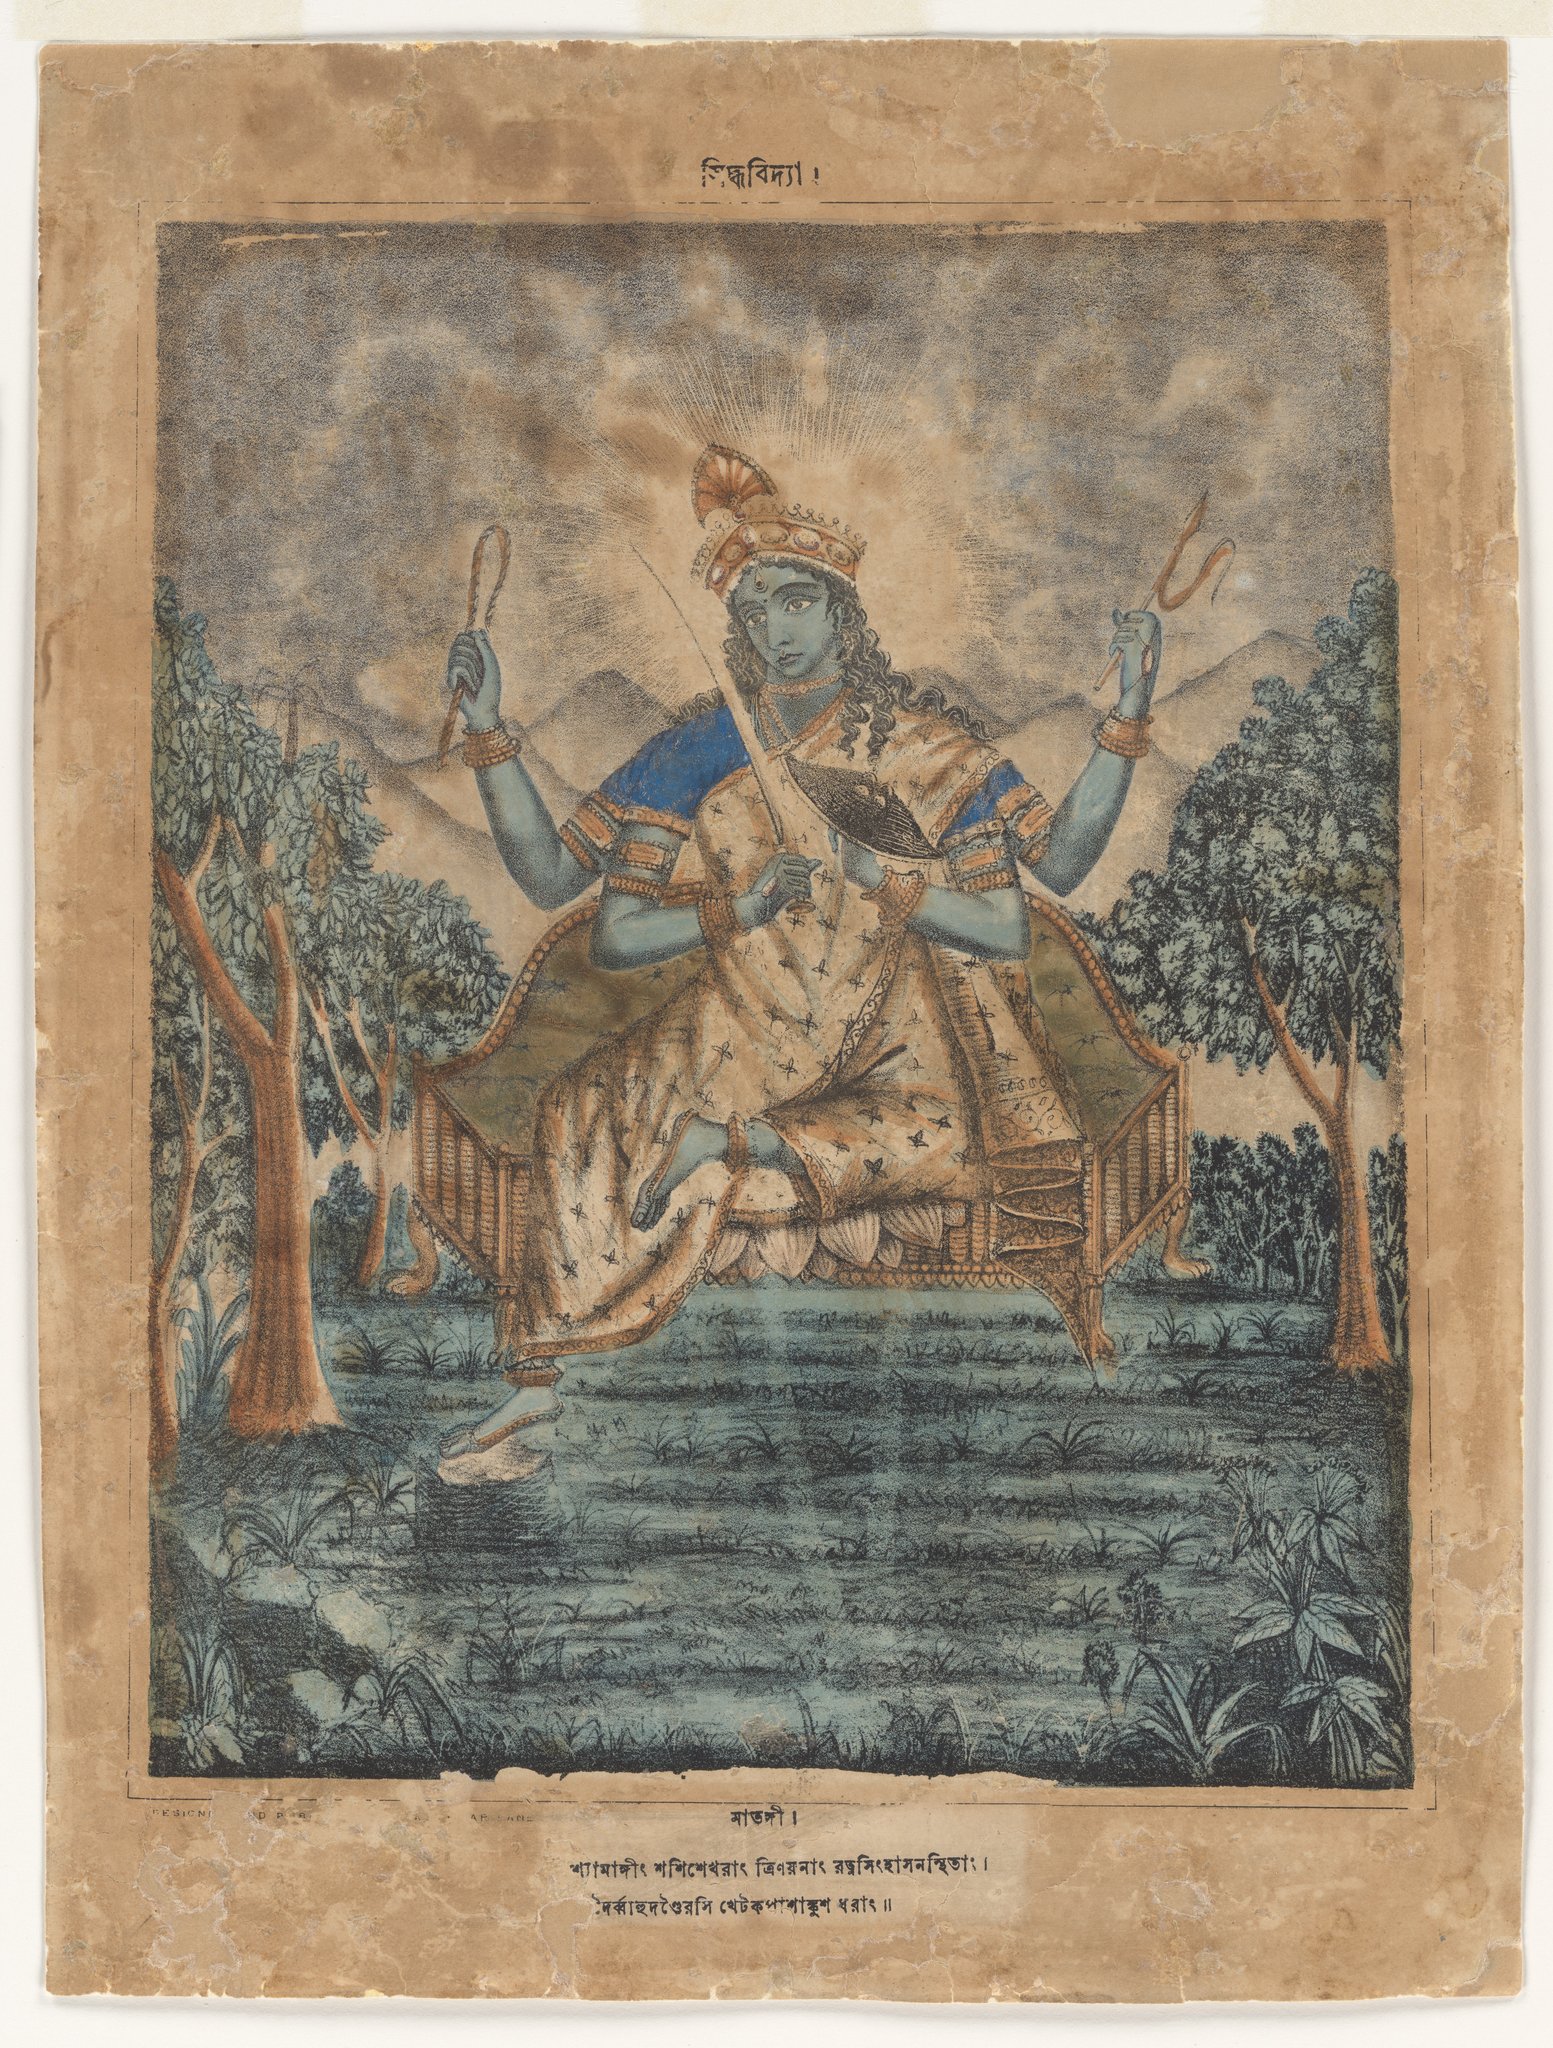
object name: lithograph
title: Goddess Matangi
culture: west bengali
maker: sasadhar banarjee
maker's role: artist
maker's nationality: indian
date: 1875-1885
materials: glaze, watercolor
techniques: hand coloring, lithograph, printing